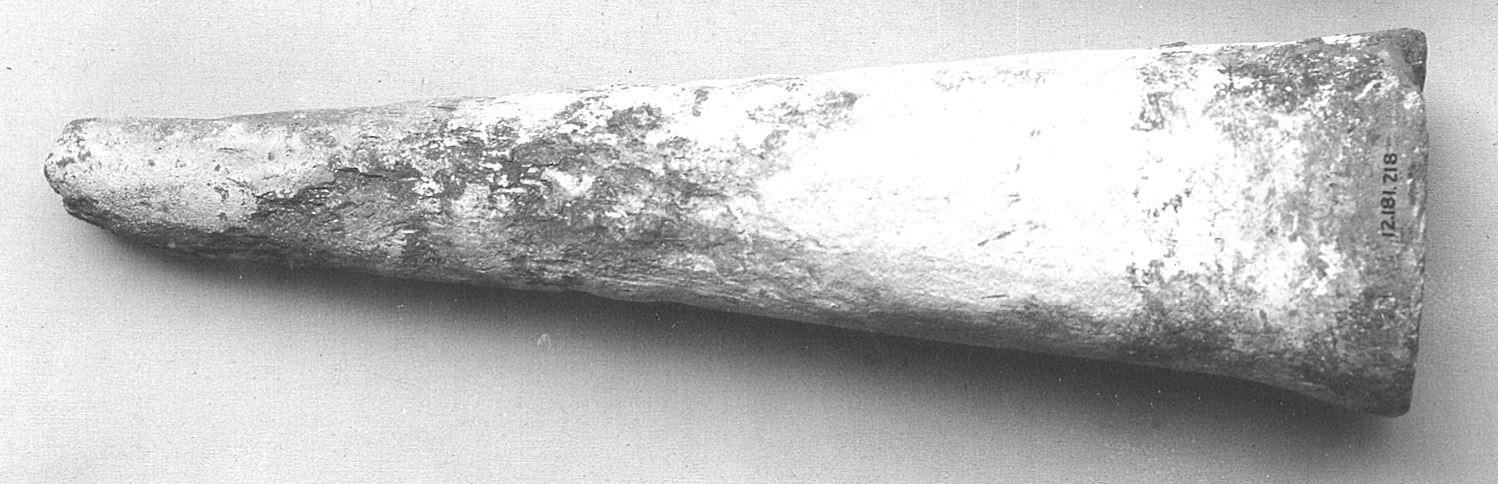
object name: cone, uninscribed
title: Uninscribed Funerary Cone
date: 2124-1981 BCE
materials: paint, pottery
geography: egypt